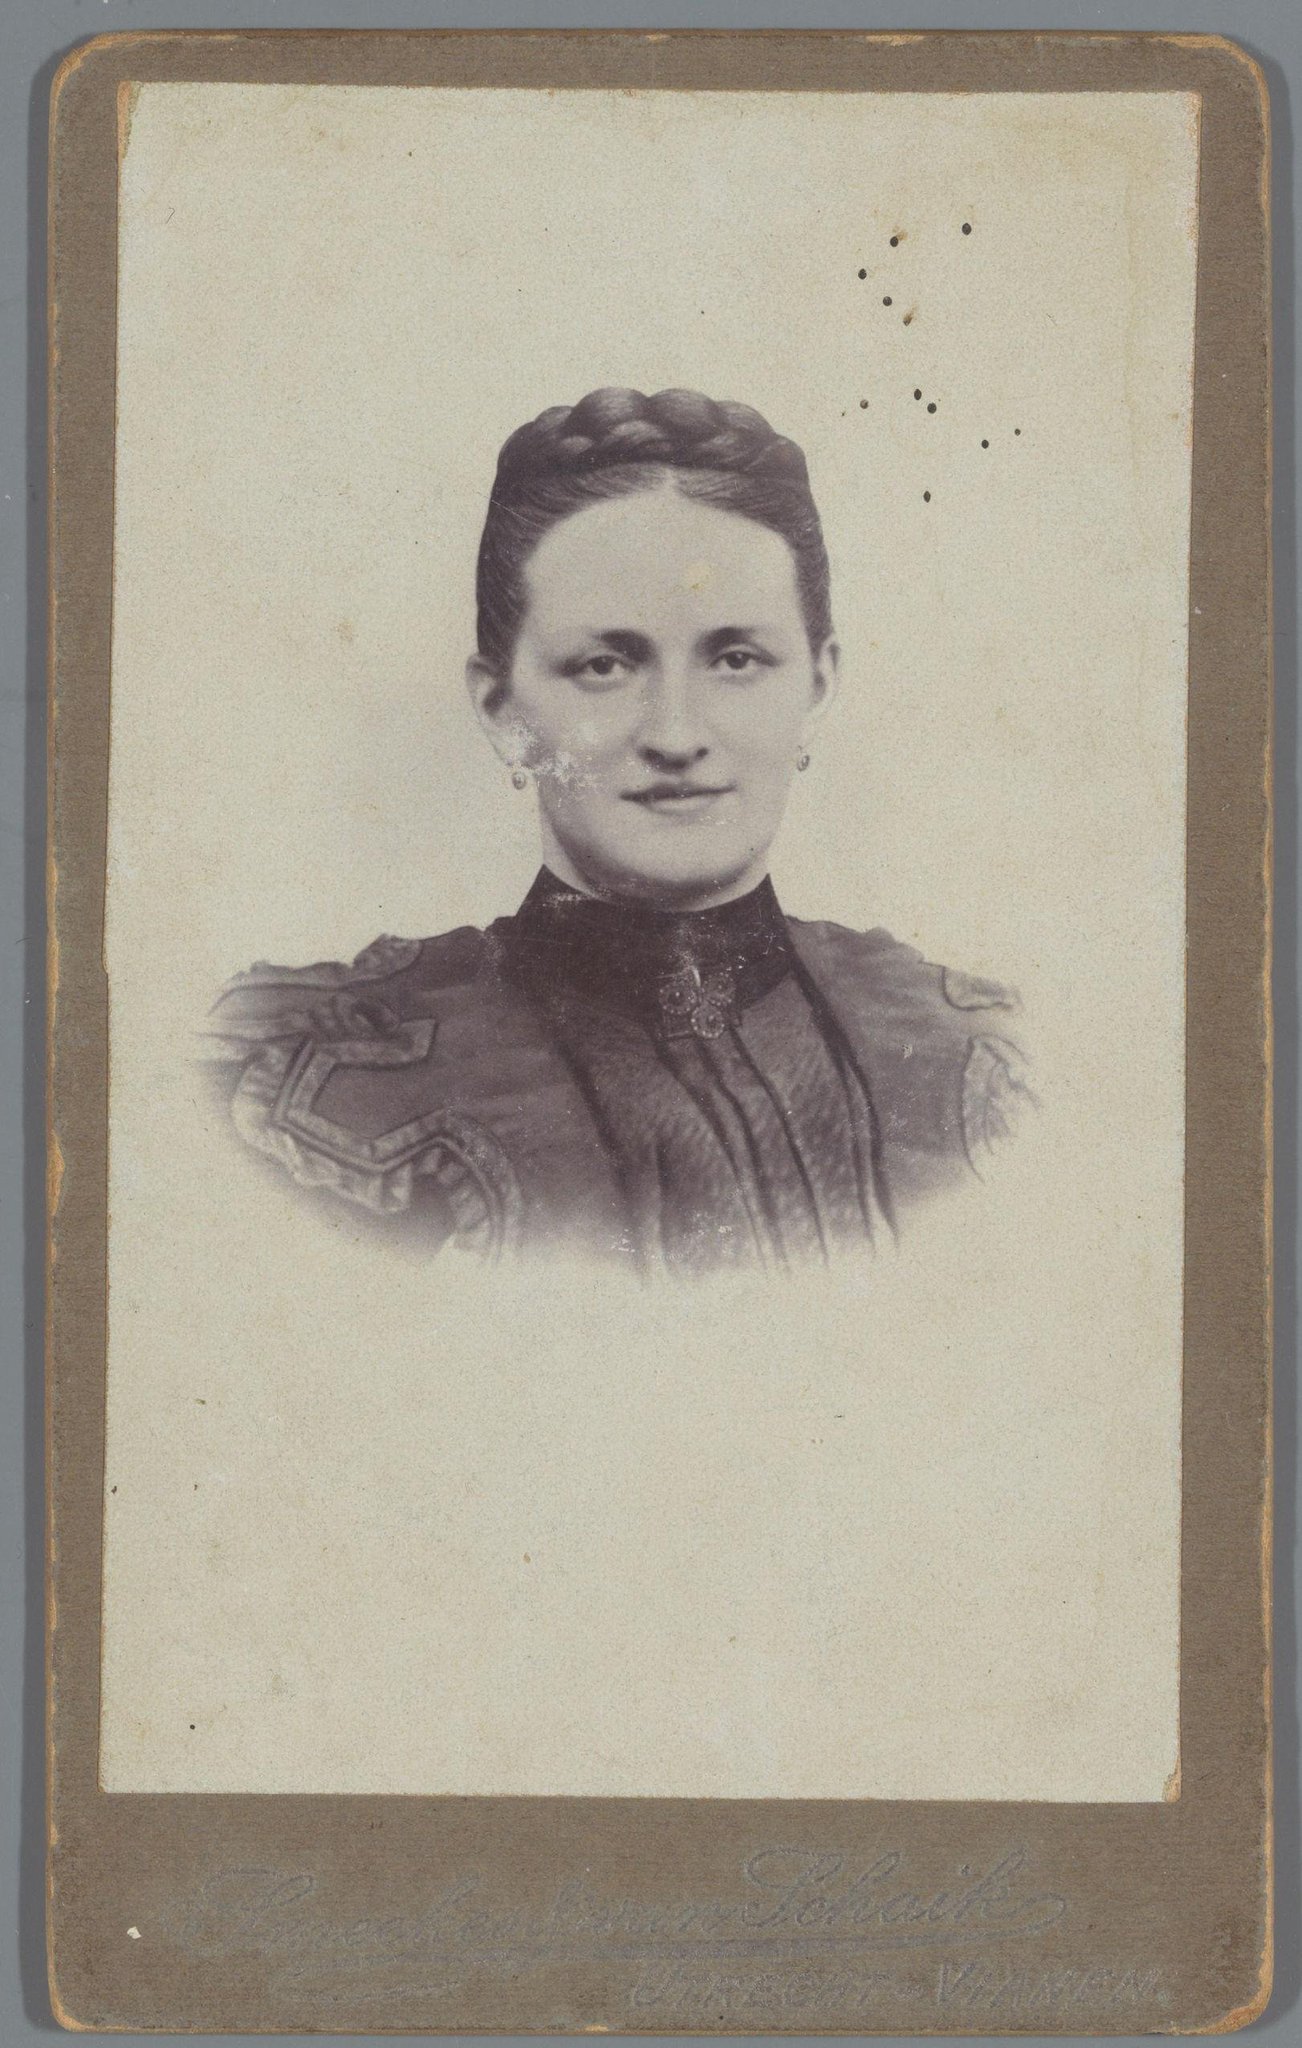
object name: carte de visite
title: Portret van een onbekende vrouw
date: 1900-1924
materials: cardboard, photographic support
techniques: collodion silver print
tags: historical persons - bb - woman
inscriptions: inscription: ‘FOTOGRAFISCHE/ ATELIERS/ van/ Smeekens & van Schaik/ Leidschekade 19/ UTRECHT/ VIANEN/ Voorstraat’